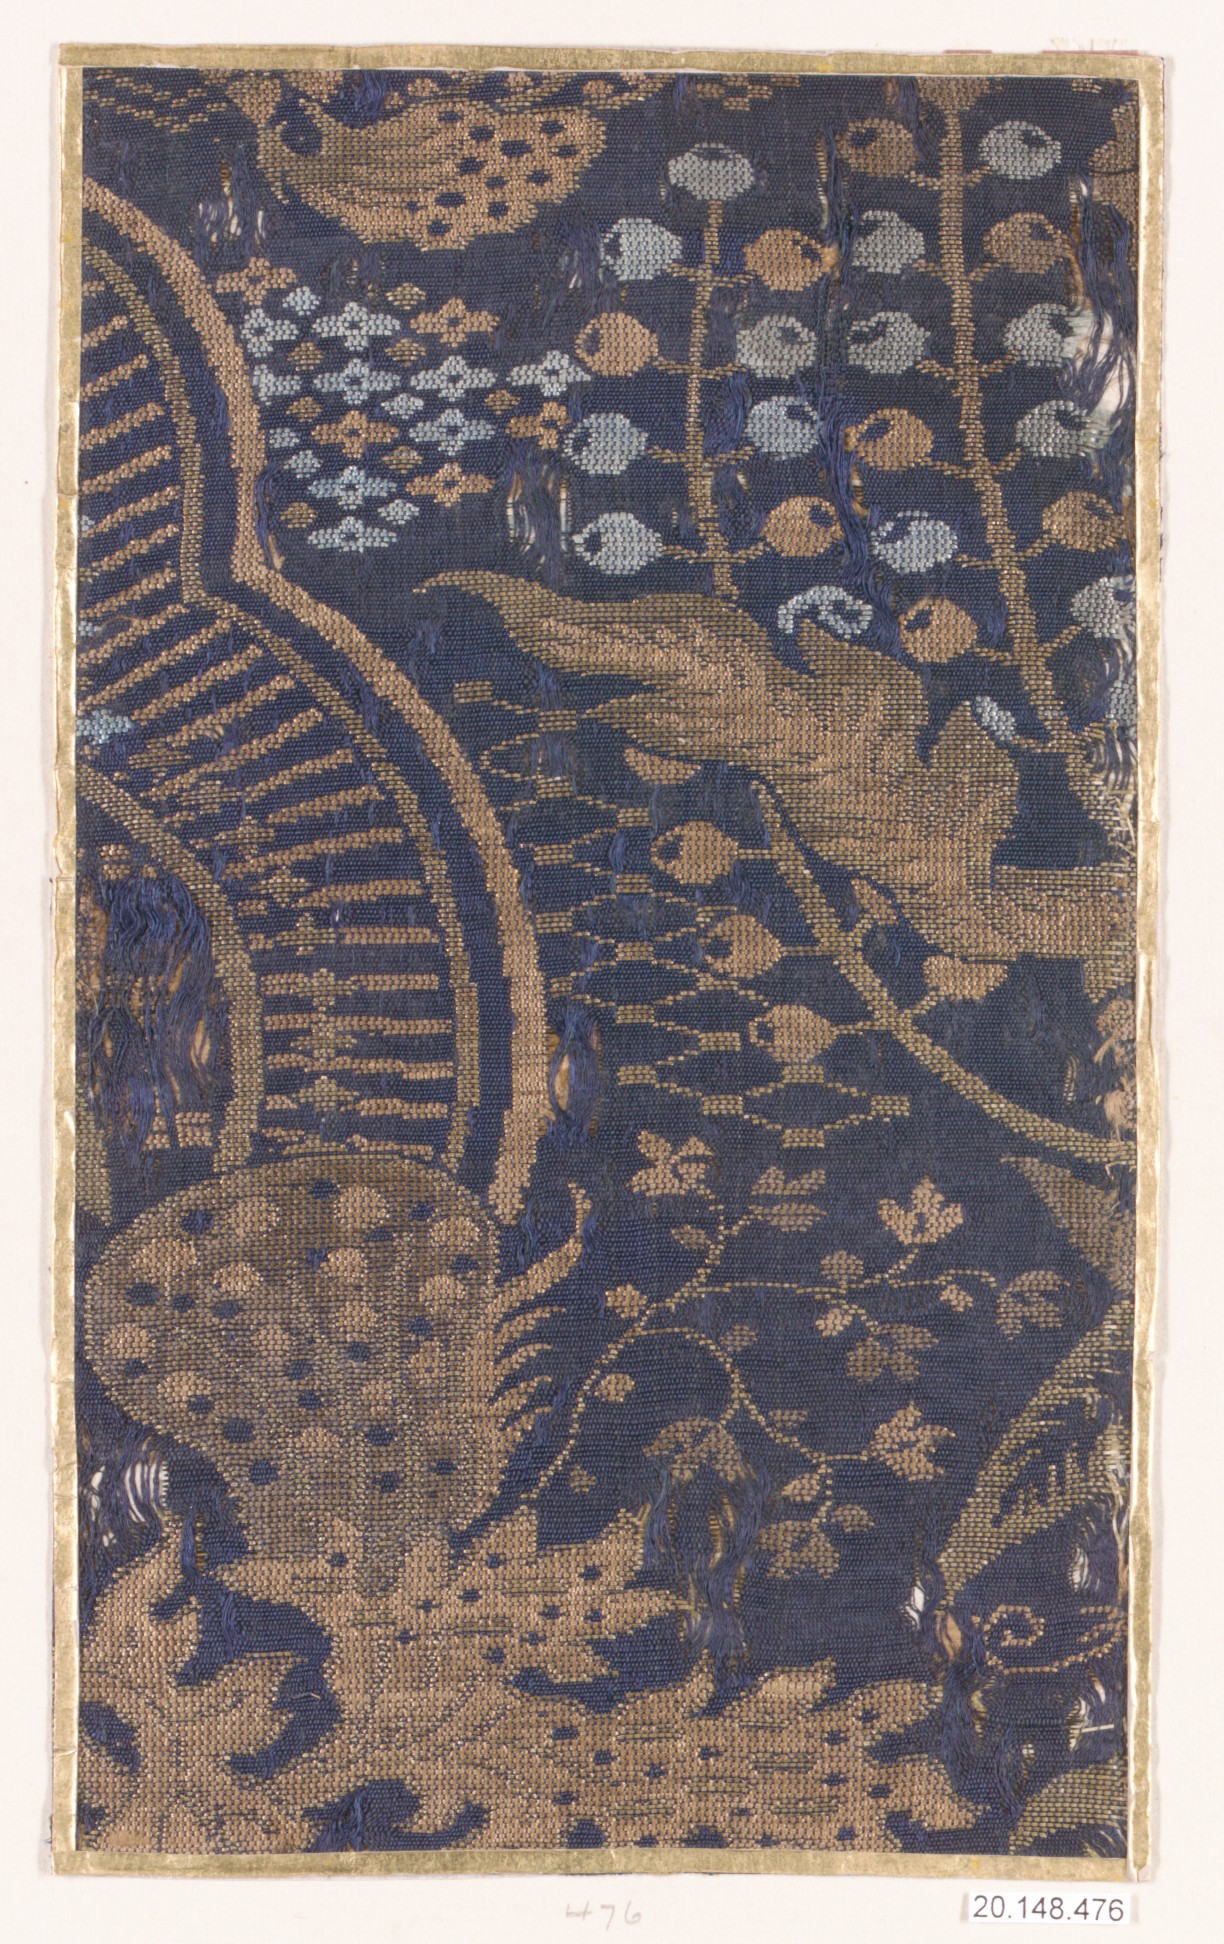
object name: piece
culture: japanese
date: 1601-1700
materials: silk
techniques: compound weave